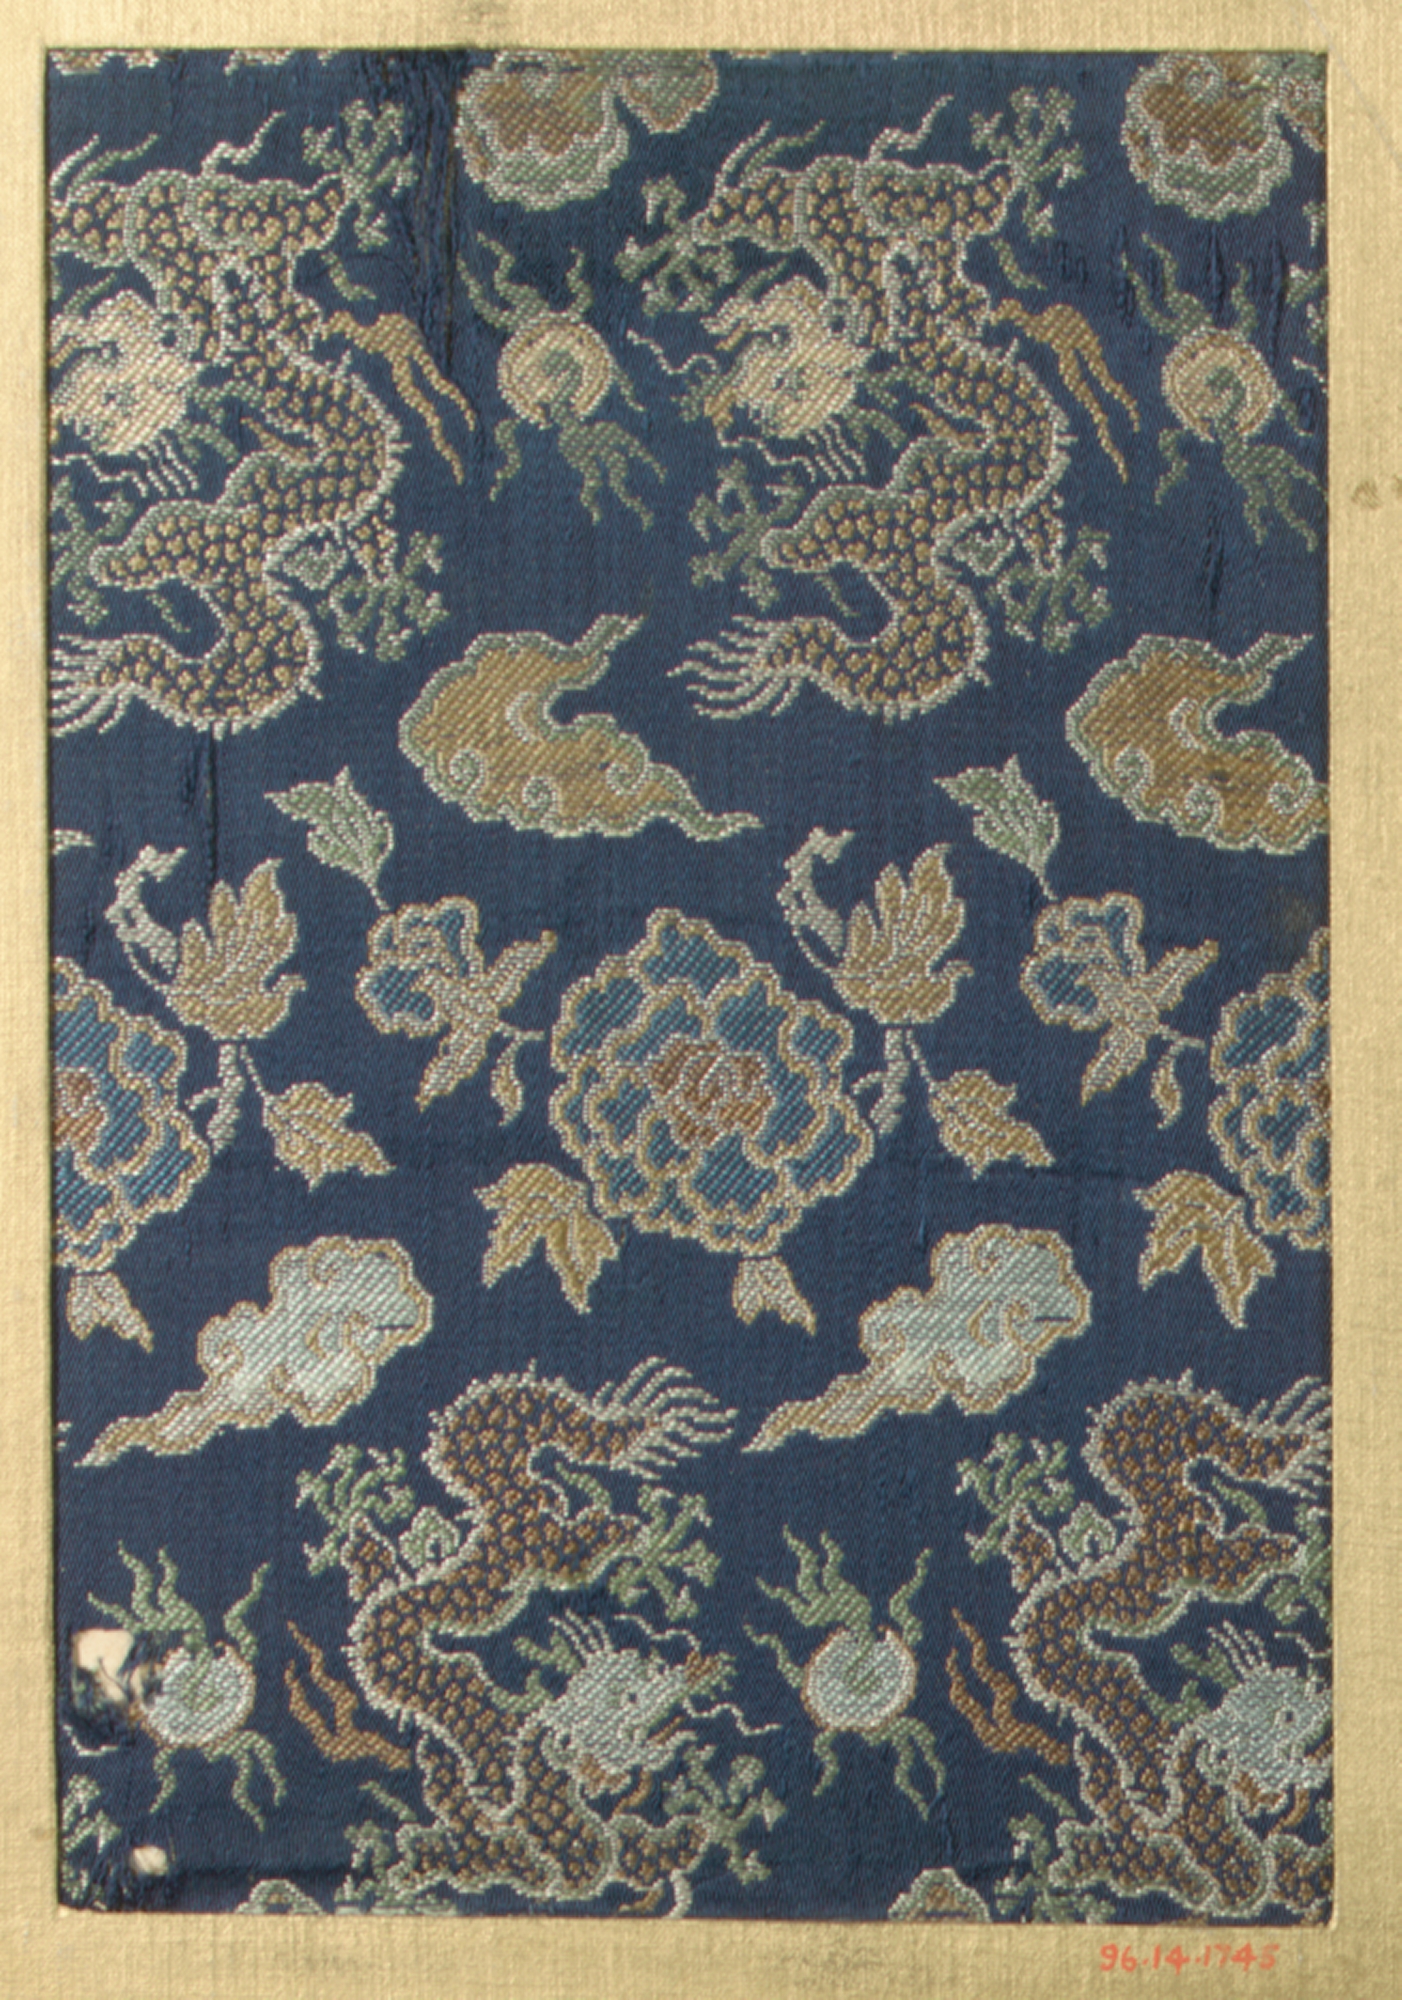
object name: piece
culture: japanese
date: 1701-1900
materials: silk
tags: flowers